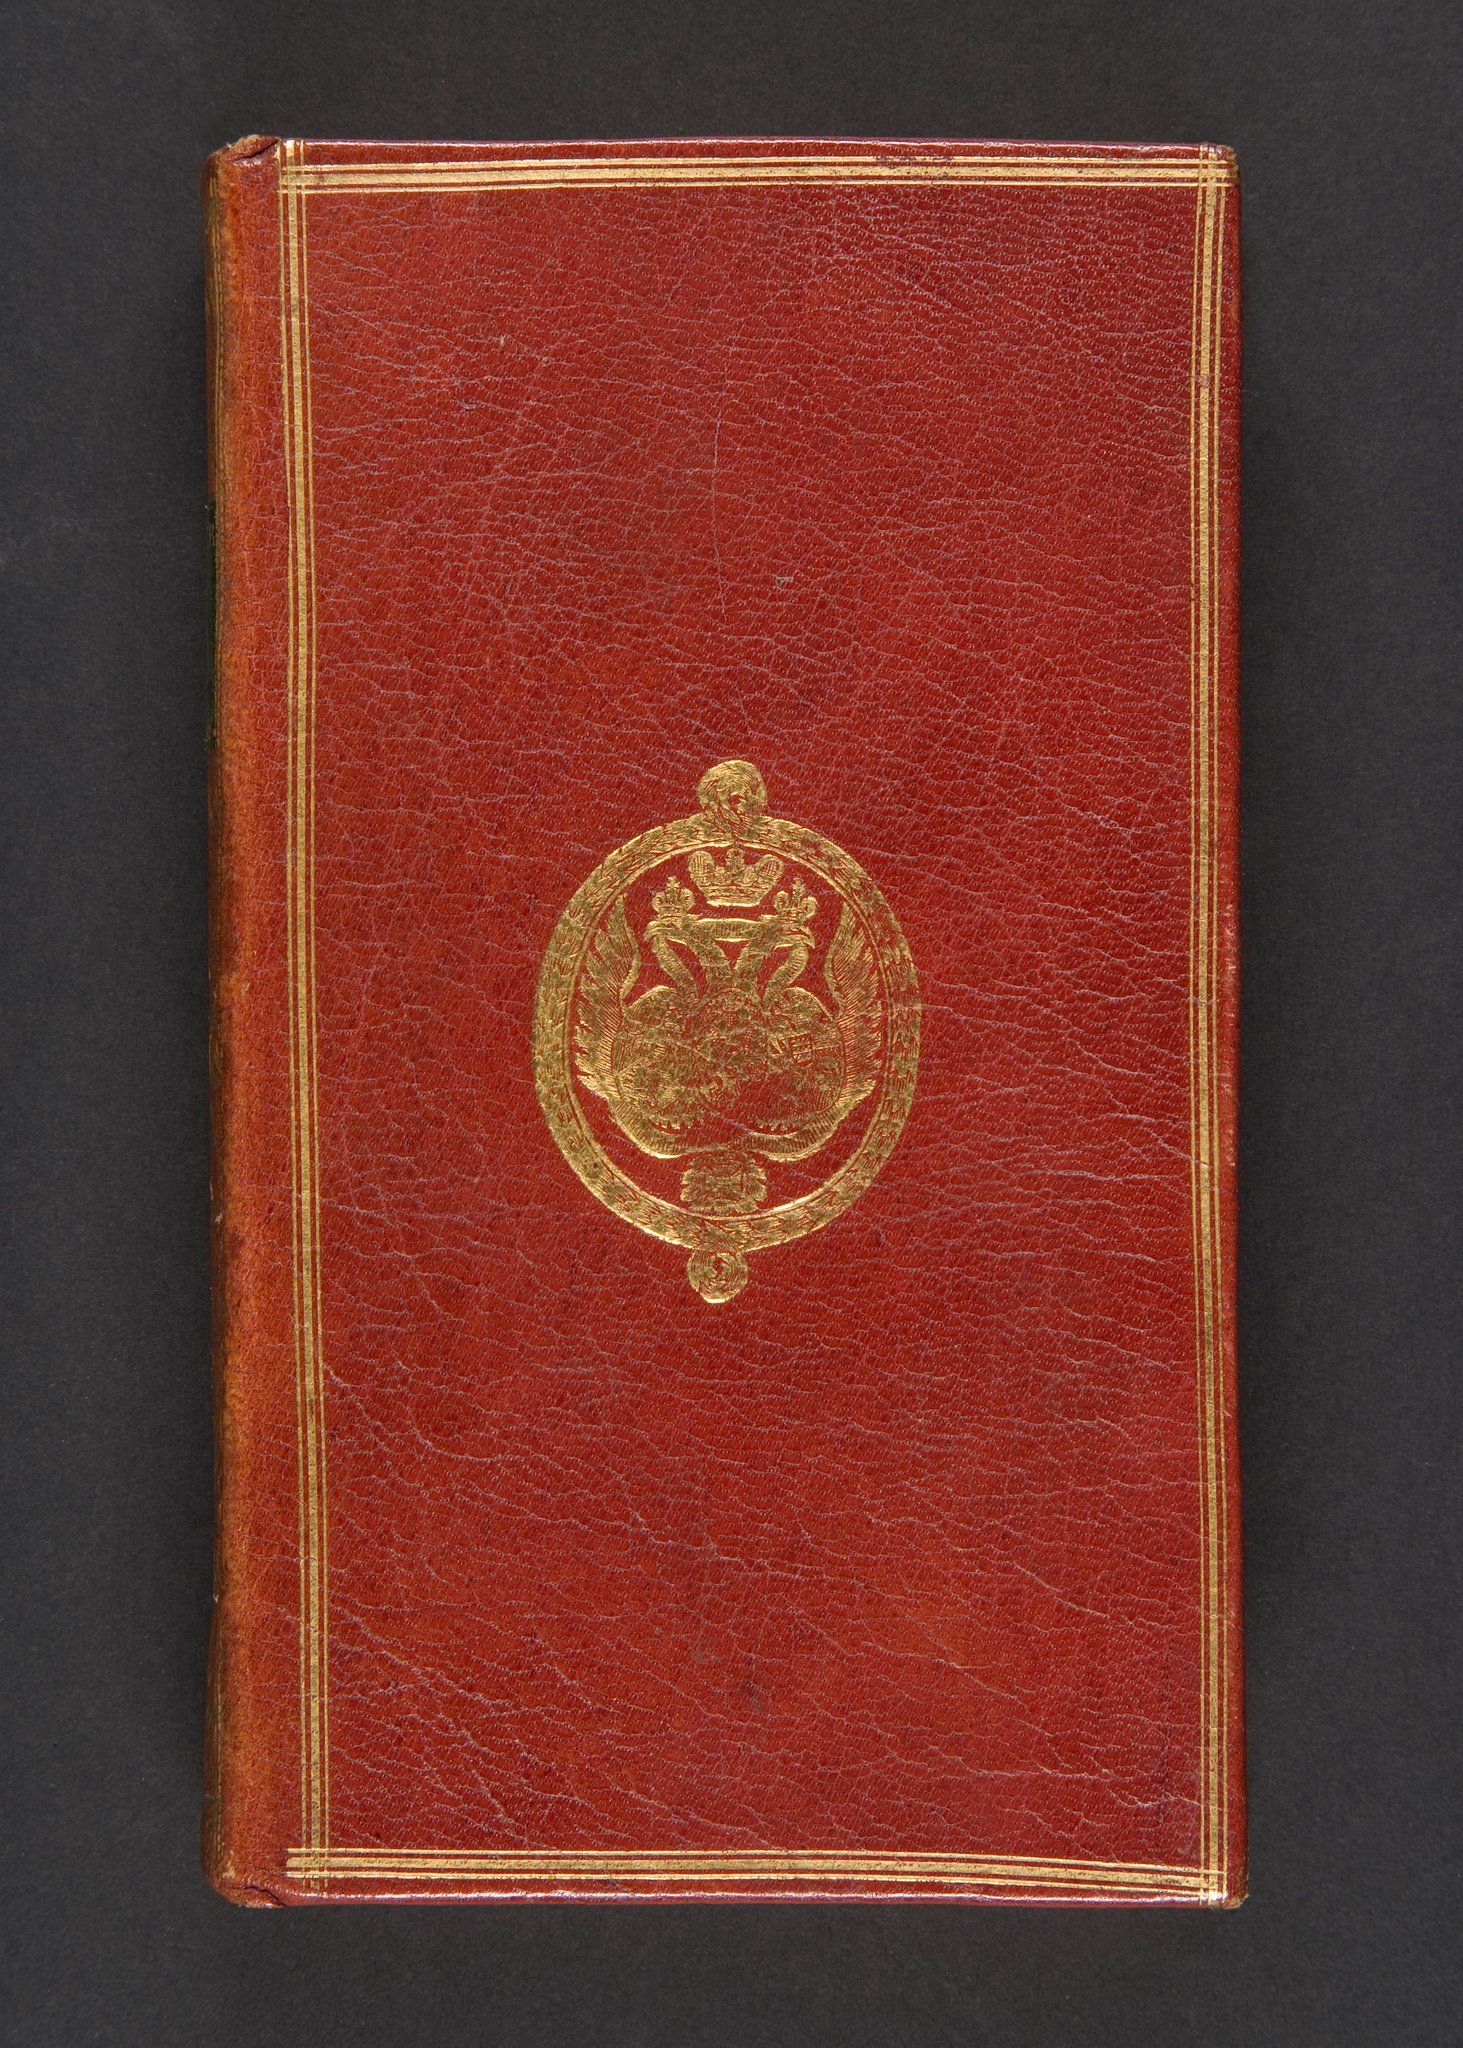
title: Memoires et réflexions sur les principaux évenemens du regne de Louis XIV, & sur le caractere de ceux qui y ont eu la principale part. Par mr. l.m.d.L.F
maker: charles auguste, marquis de la fare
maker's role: author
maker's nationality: french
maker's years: 1644-1712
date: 1749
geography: netherlands